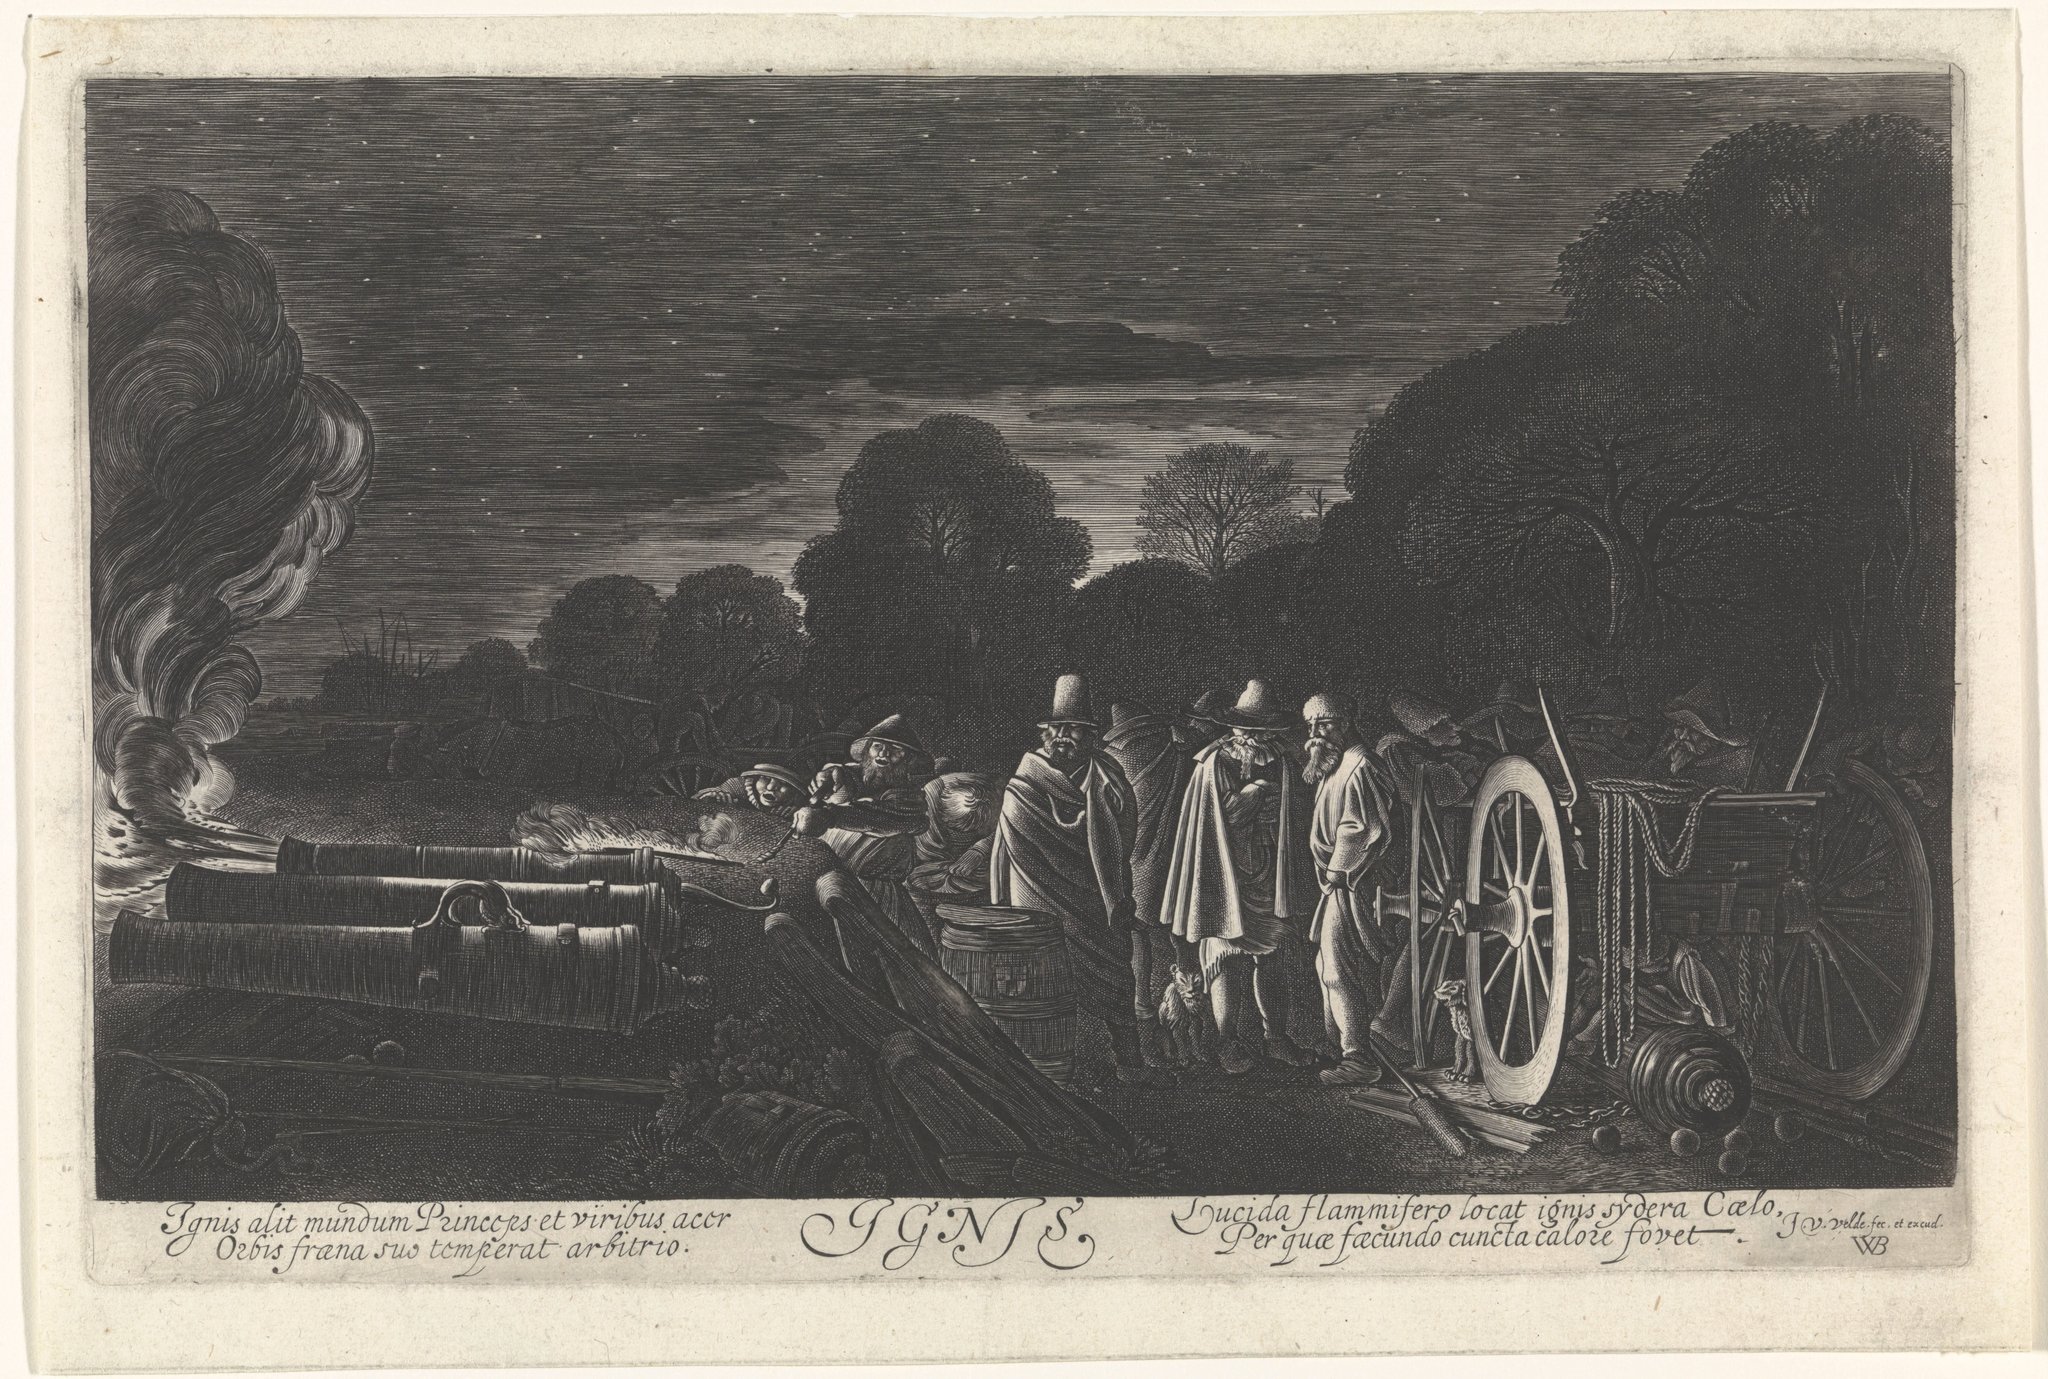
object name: print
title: Vuur (Ignis)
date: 1603-1641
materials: paper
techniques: engraving, etching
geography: northern netherlands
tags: night ~ other concepts, fire (one of the four elements), firearms: cannon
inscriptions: title: ‘IGNIS’, collector's mark: Lugt 964, signature: ‘J.V.Velde fec. et excud.’, caption: ‘Ignis alit mundum Princeps et viribus acer...Per quae faecundo cuncta calore fovet.’, monogram: ‘WB’ Willem Buytewech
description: Landschap met soldaten die kanonnen afvuren bij nacht, voorstellende het element vuur. Derde prent uit een serie van vier met landschappen als verbeeldingen van de vier elementen.